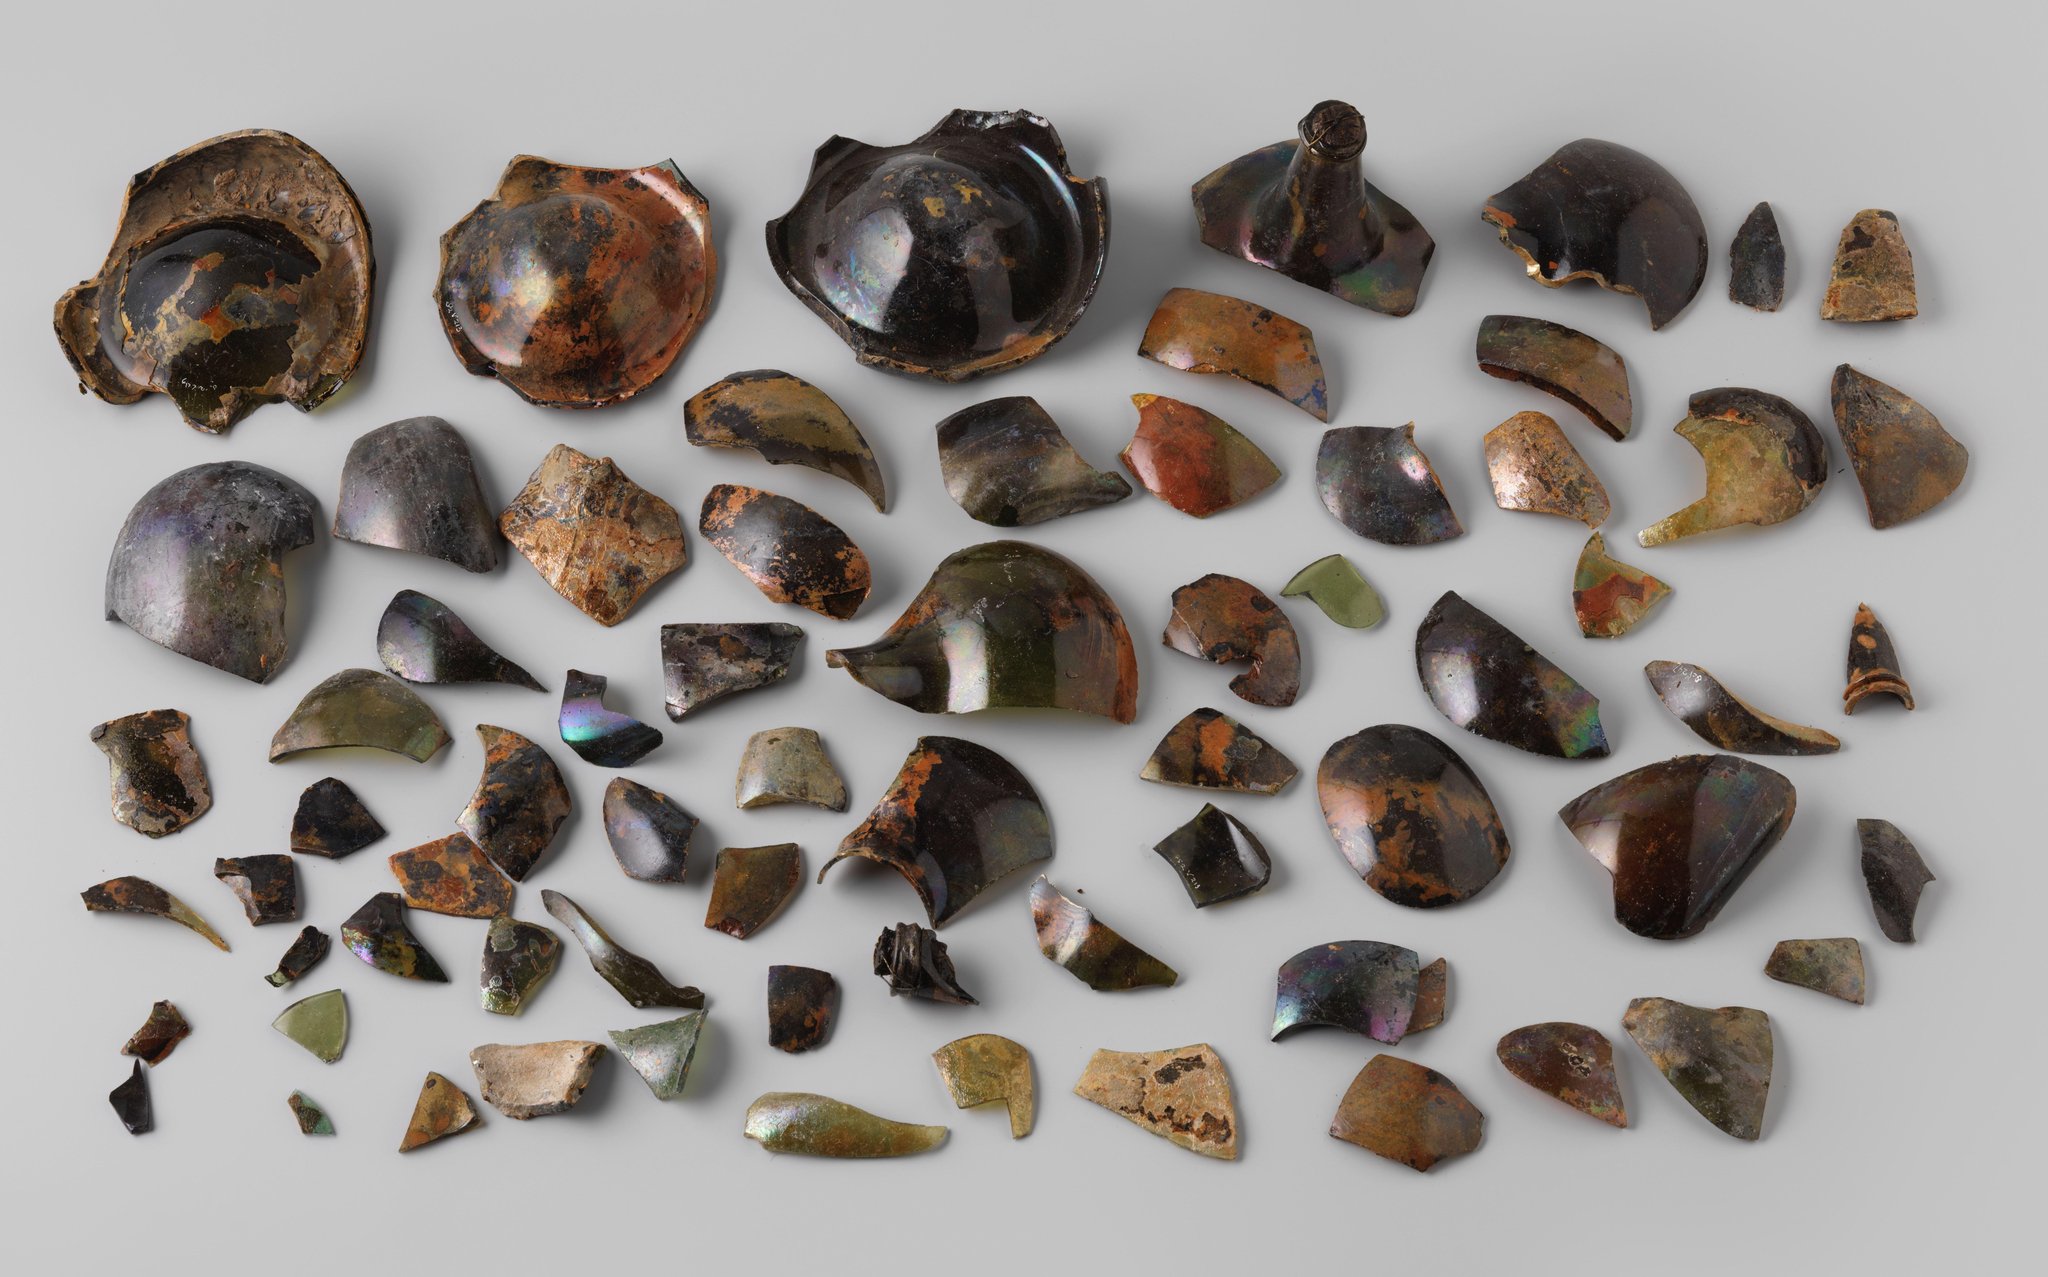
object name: wine bottle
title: Scherven van wijnflessen uit het wrak van de Oost-Indiëvaarder 't Vliegend Hart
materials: cork, glass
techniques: green glass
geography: netherlands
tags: 't vliegend hart (schip), verenigde oostindische compagnie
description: Scherven van uivormige wijnflessen van groen glas waar rode (port)wijn in heeft gezeten.